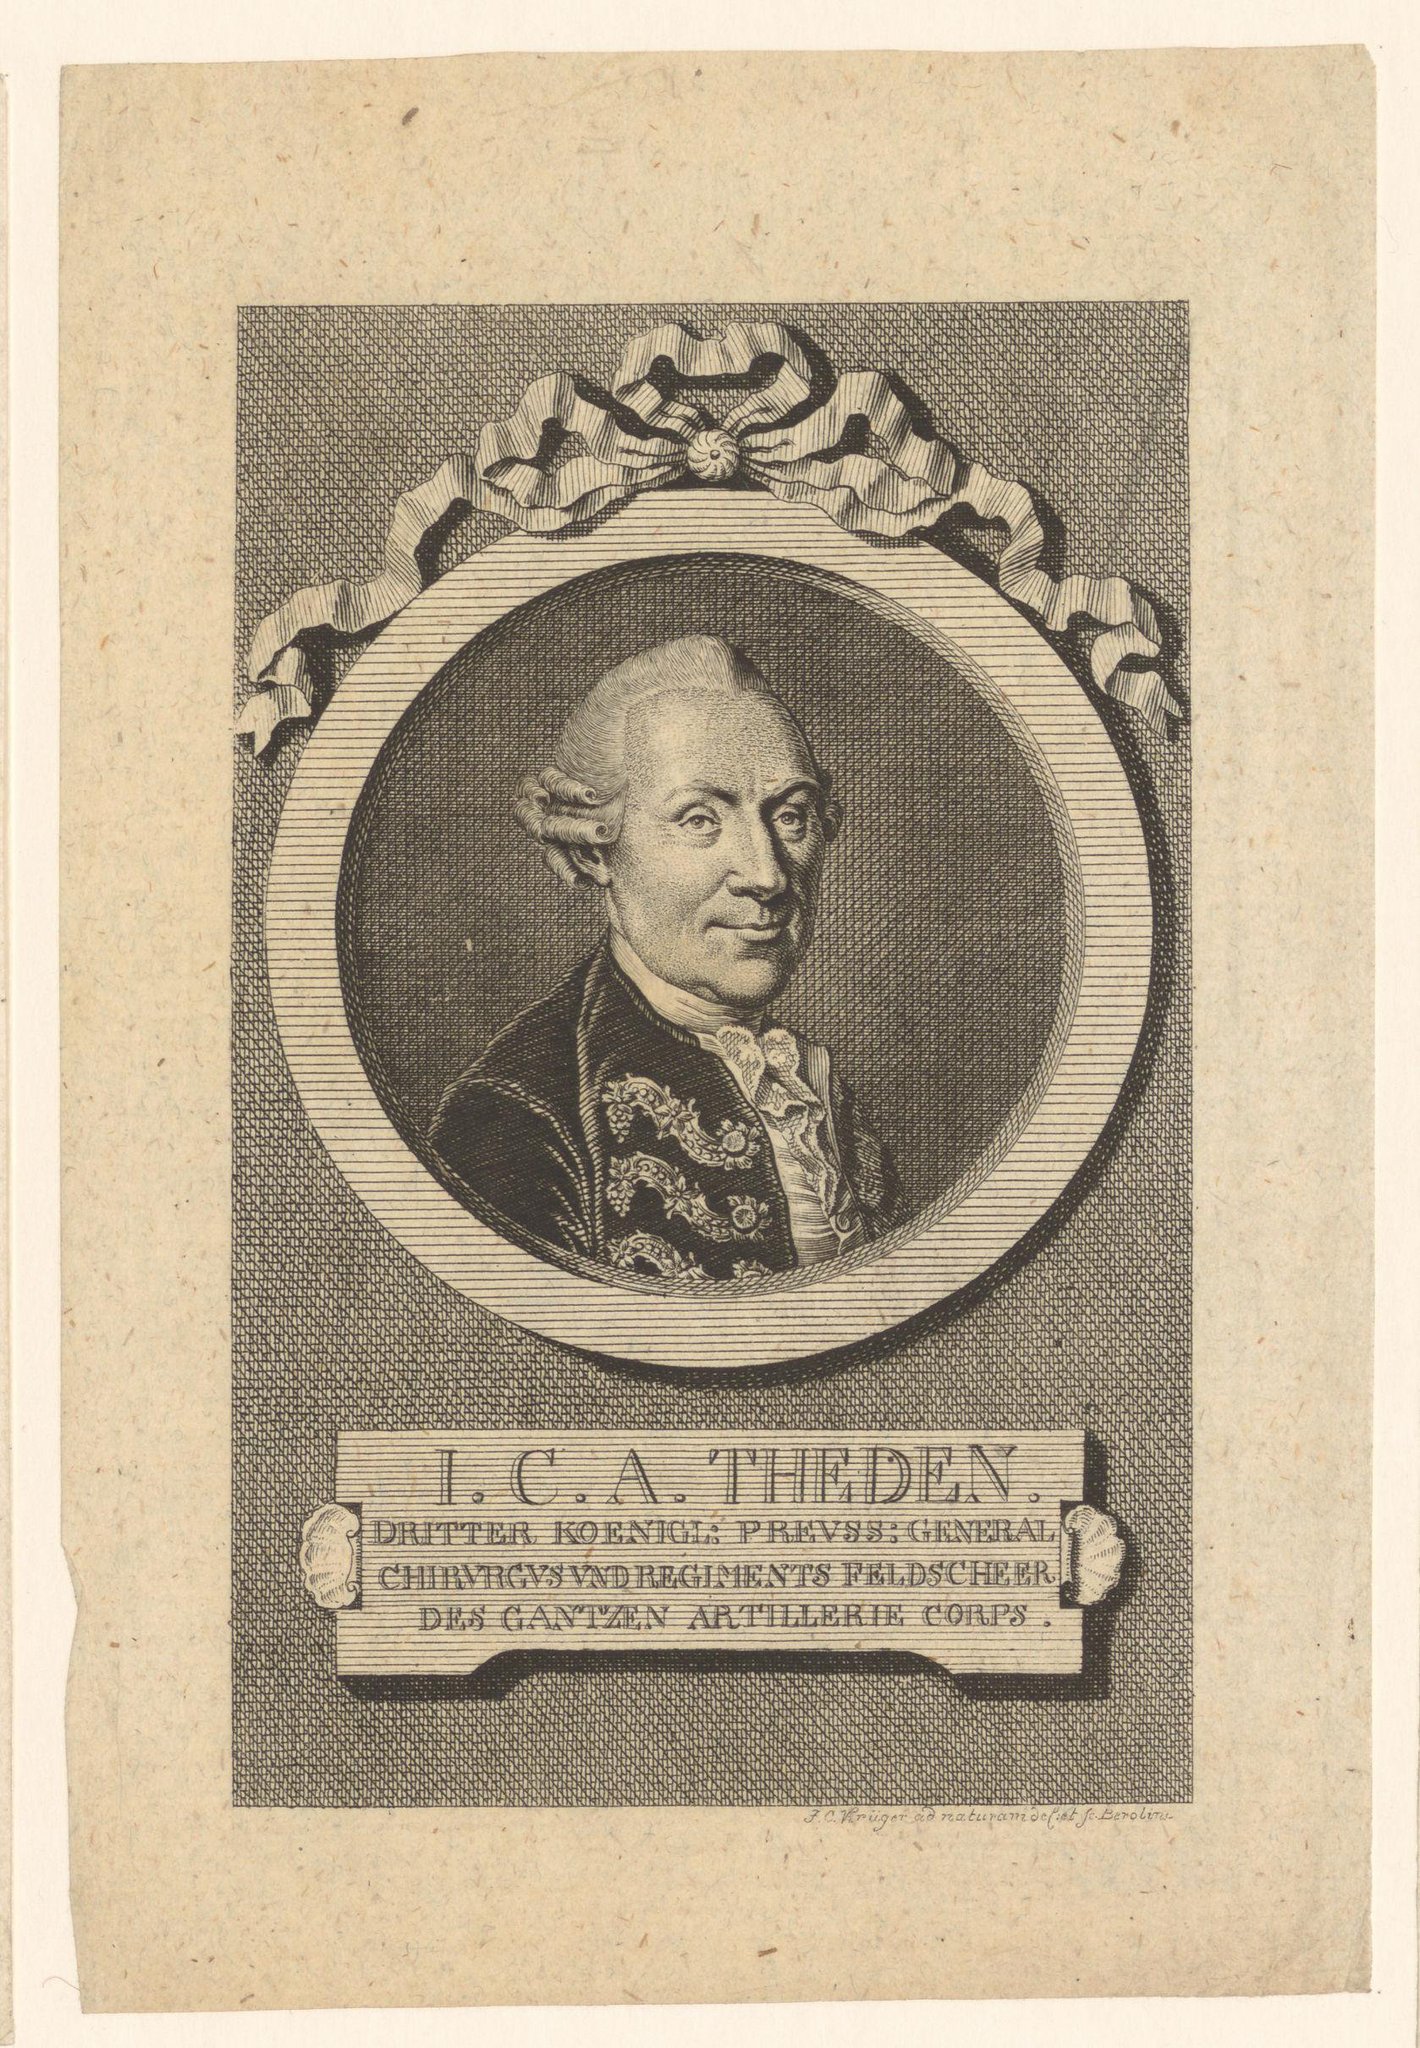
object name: print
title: Portret van Johann Christian Anton Theden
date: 1777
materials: paper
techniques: engraving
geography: berlin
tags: further education (+ portrait of teacher, professor), historical persons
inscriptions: collector's mark: Lugt 2228